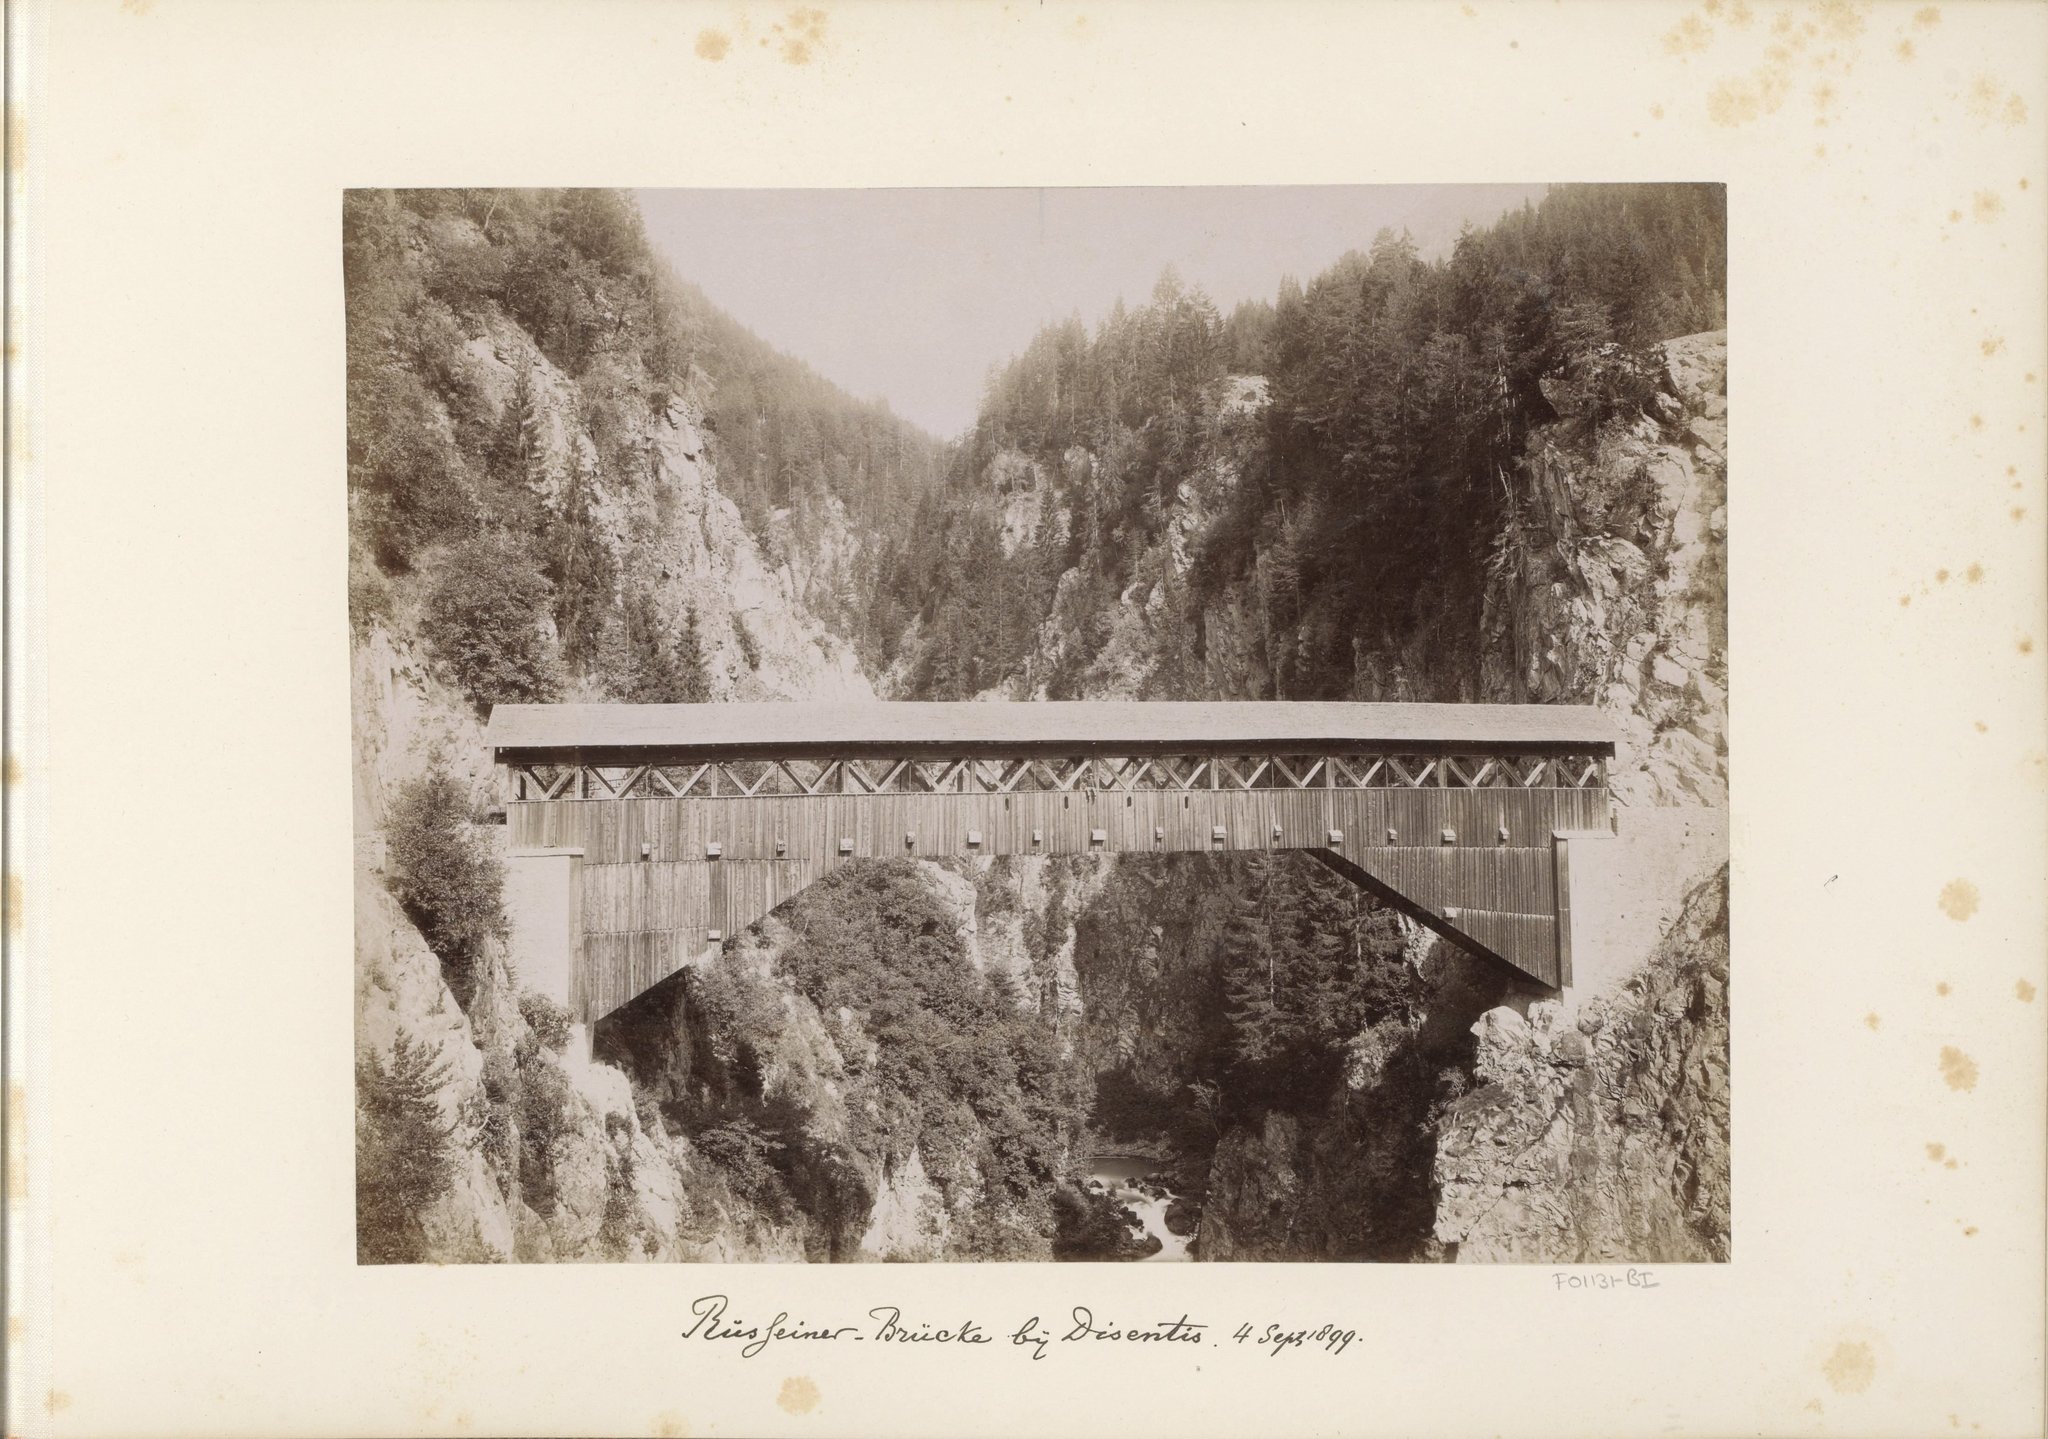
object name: photograph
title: Houten Russeinerbrug bij Disentis-Mustér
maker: Anonymous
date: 1880-1899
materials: paper, photographic support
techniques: albumen print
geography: disentis-mustér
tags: landscape with bridge, viaduct or aqueduct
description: Onderdeel van Reisalbum met bezienswaardigheden in Duitsland, Oostenrijk, Zwitserland, Luxemburg en België.